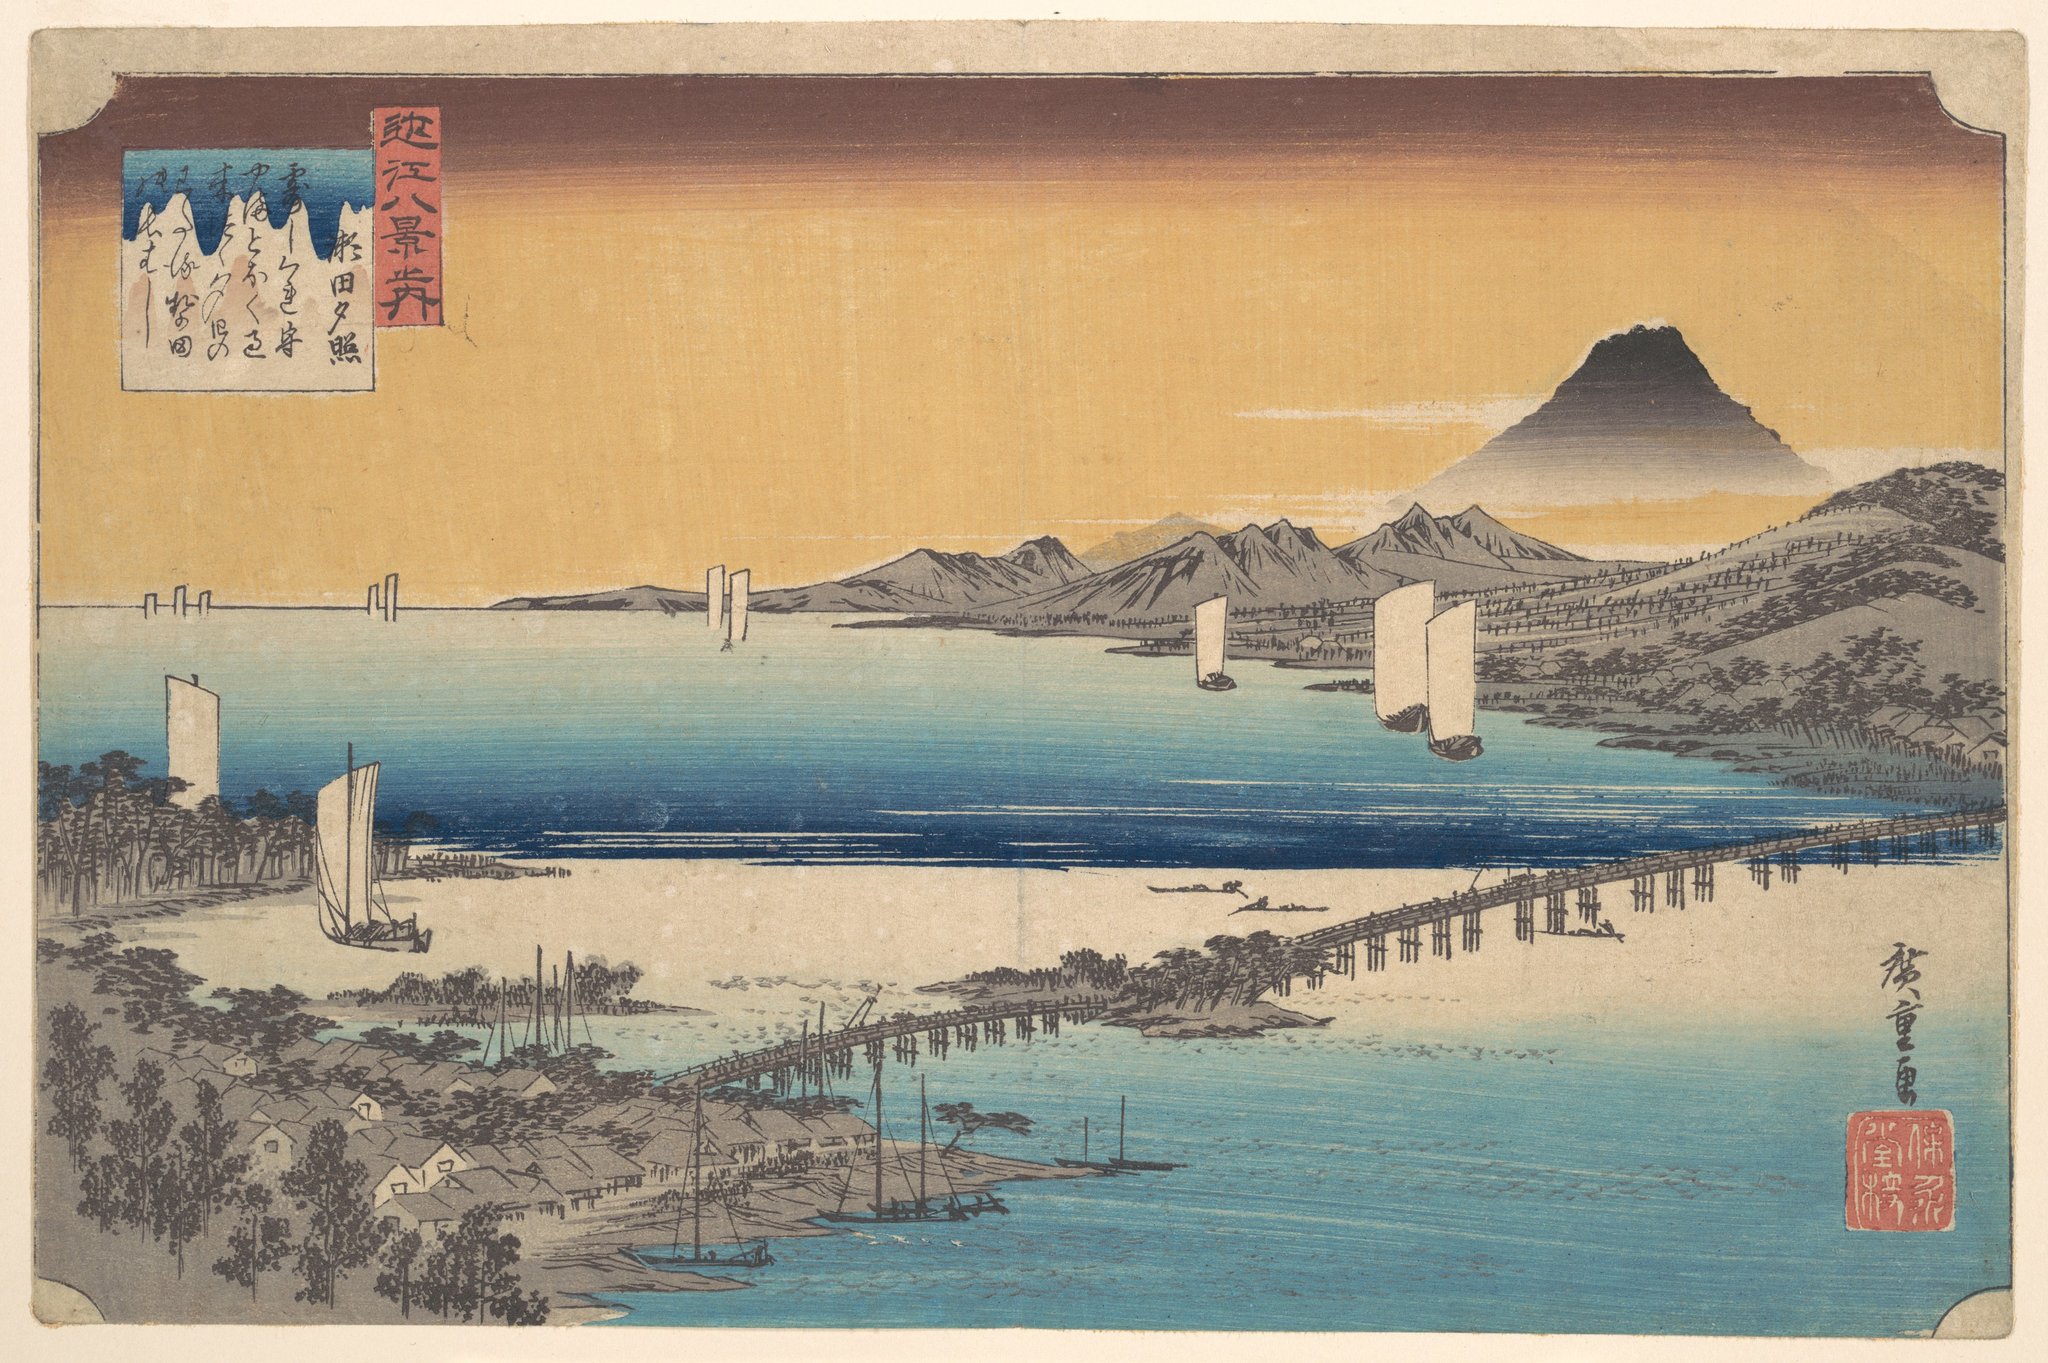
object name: print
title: Long Bridge of Seta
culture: japanese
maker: utagawa hiroshige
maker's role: artist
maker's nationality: japanese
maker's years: 1797-1858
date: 1797-1858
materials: ink, paper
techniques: woodblock print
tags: houses,bridges,mountains,trees,boats